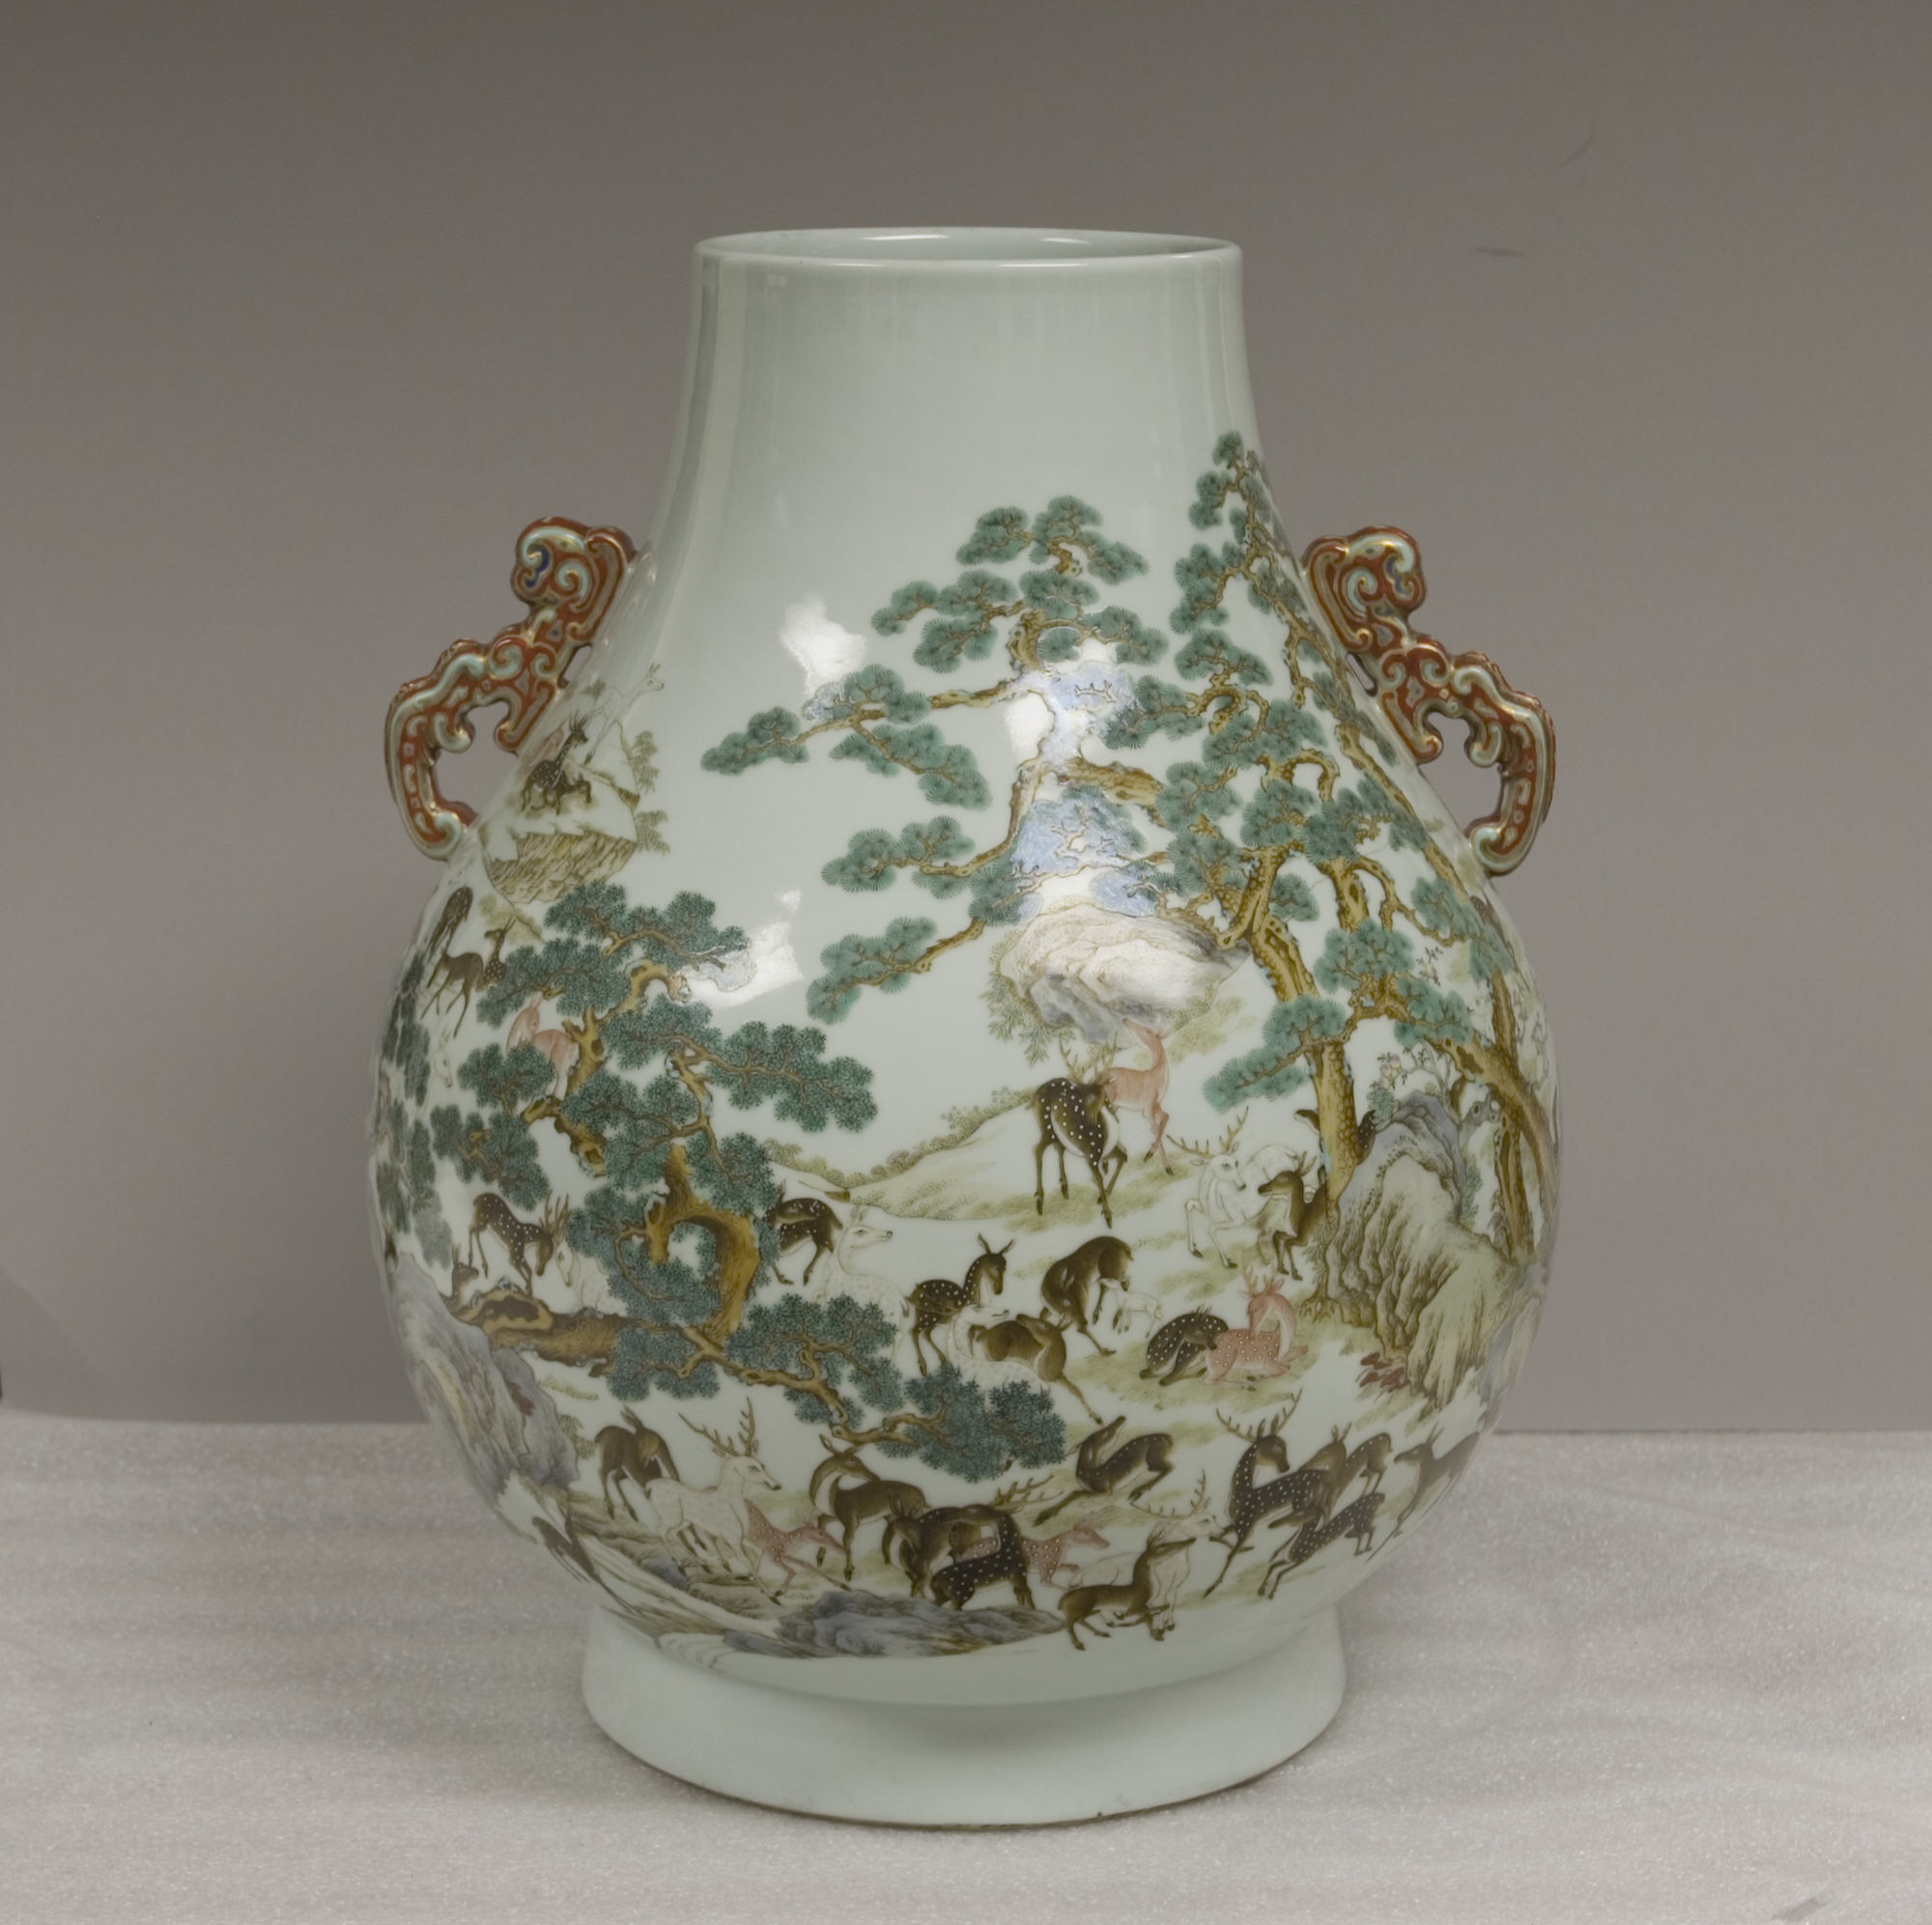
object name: vase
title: Vase with the “One Hundred Deer” motif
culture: chinese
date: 1751-1800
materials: enamel, porcelain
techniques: overglaze, painting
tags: deer,trees